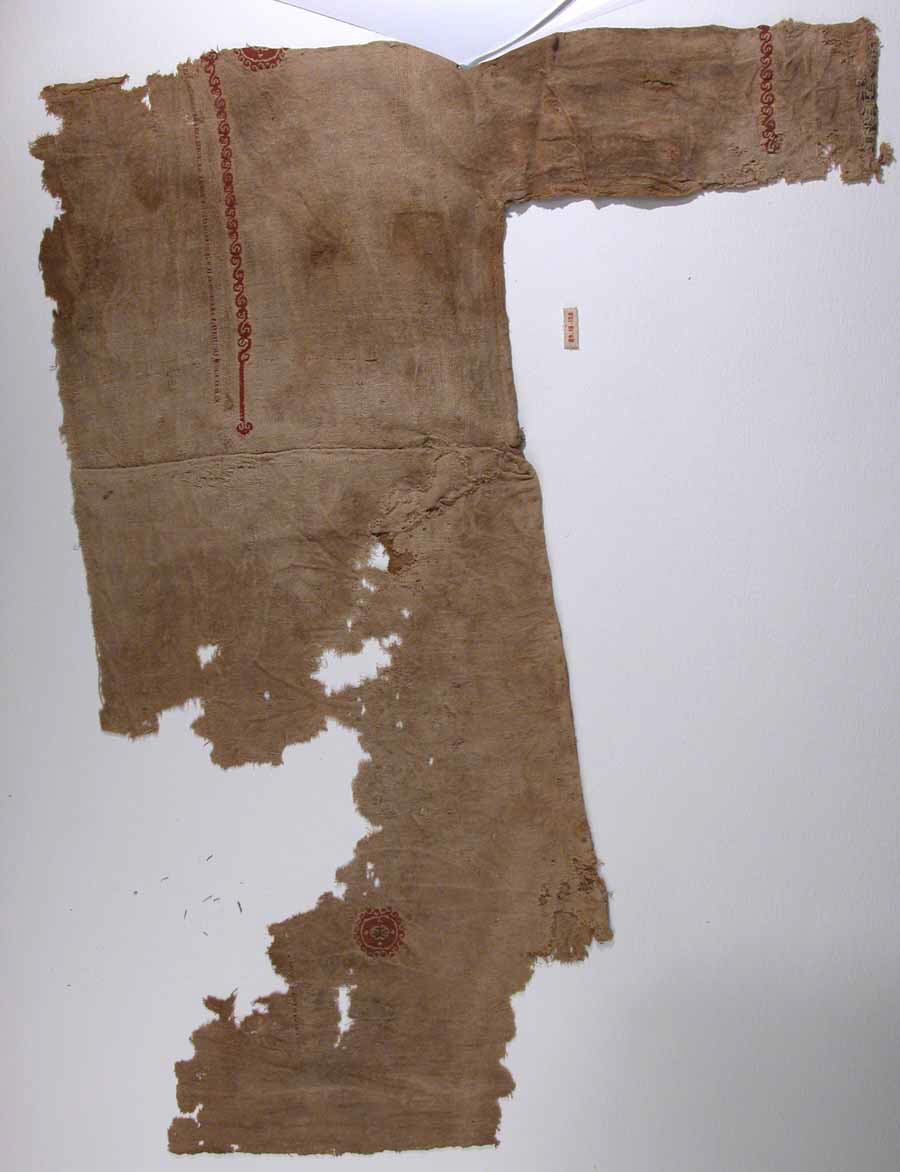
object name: textile fragment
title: Fragment of a Tunic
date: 401-600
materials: linen, wool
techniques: weave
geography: egypt